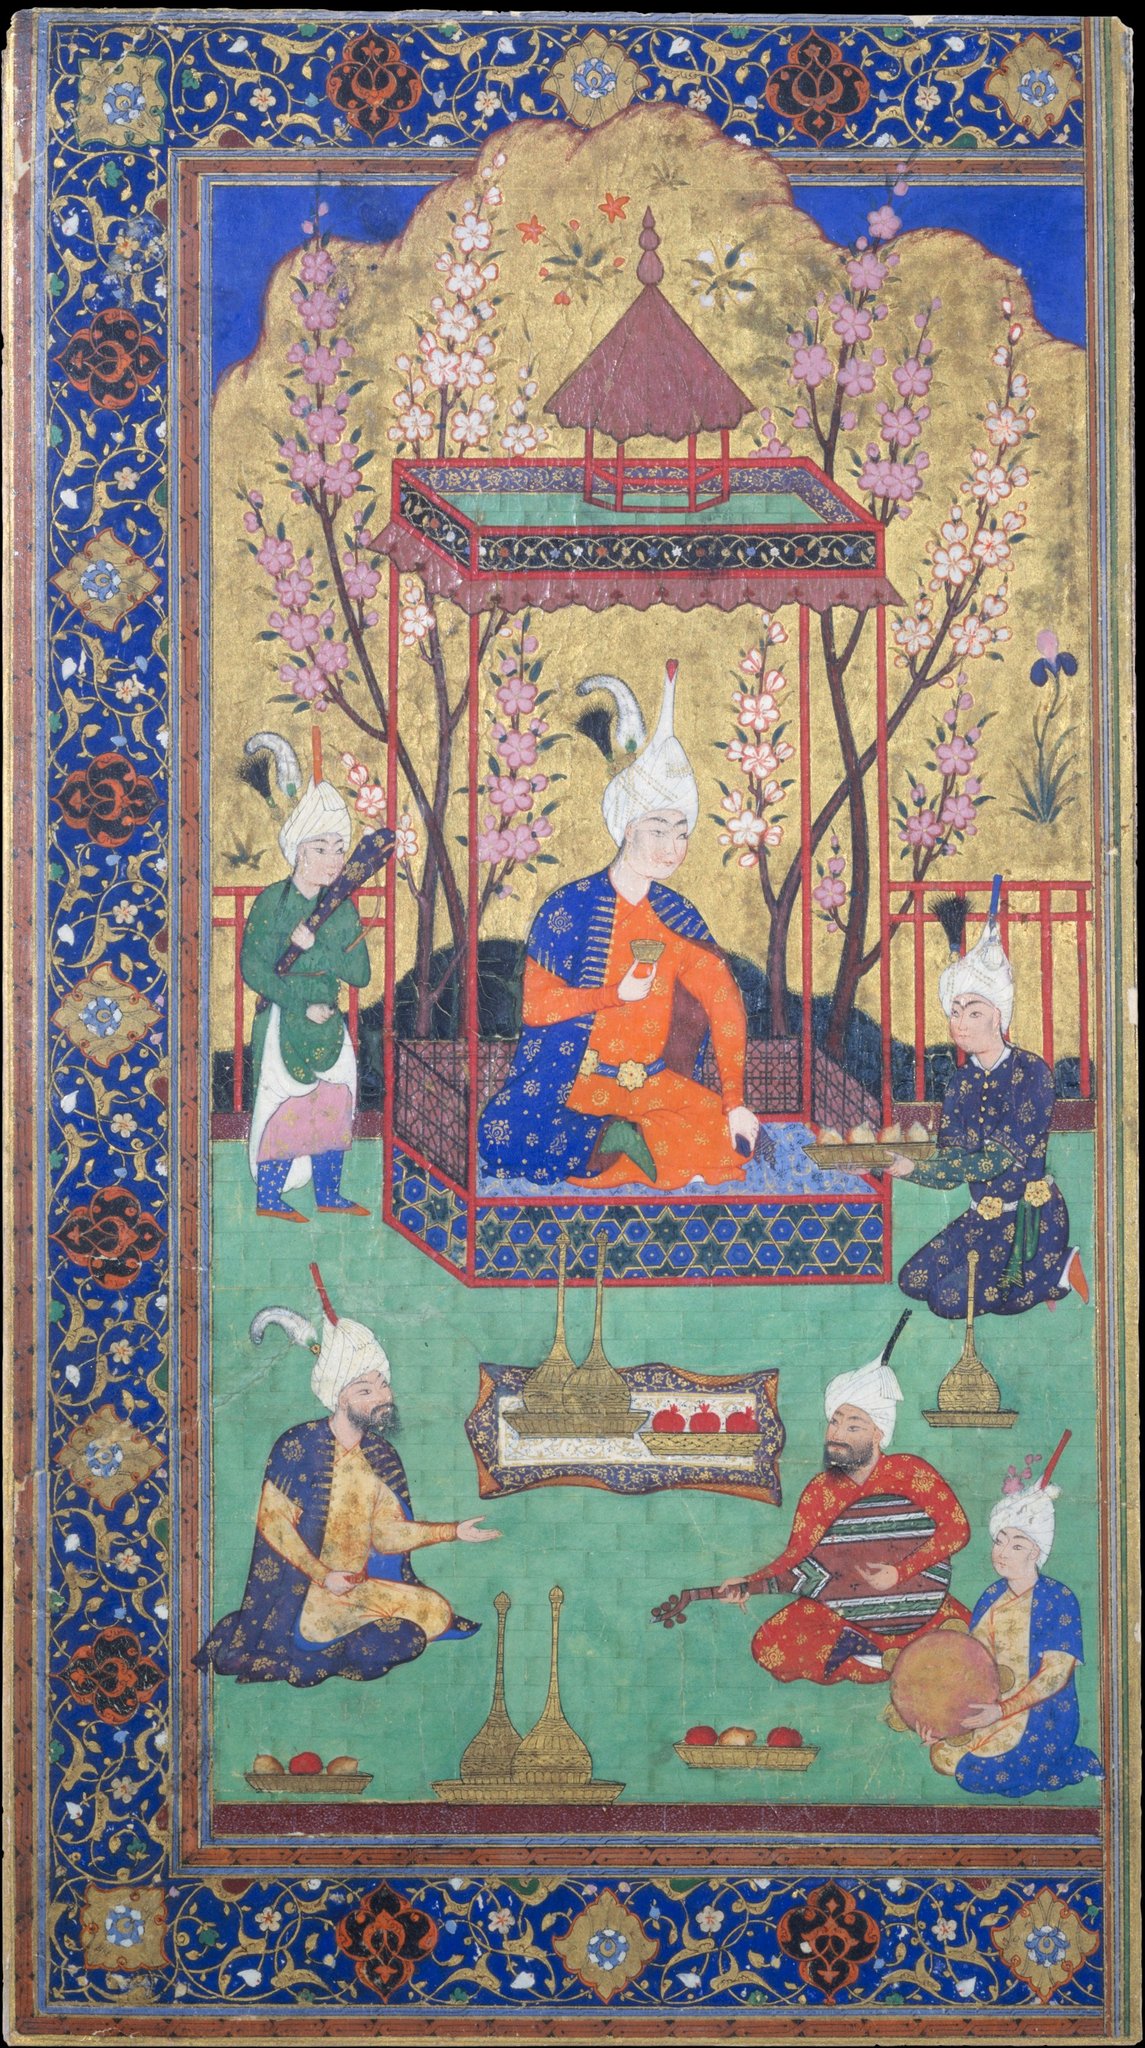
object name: folio from an illustrated manuscript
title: Prince in a Garden Courtyard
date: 1525-1530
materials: gold, ink, paper, silver, watercolor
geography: iran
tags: musical instruments,gardens,princes,men